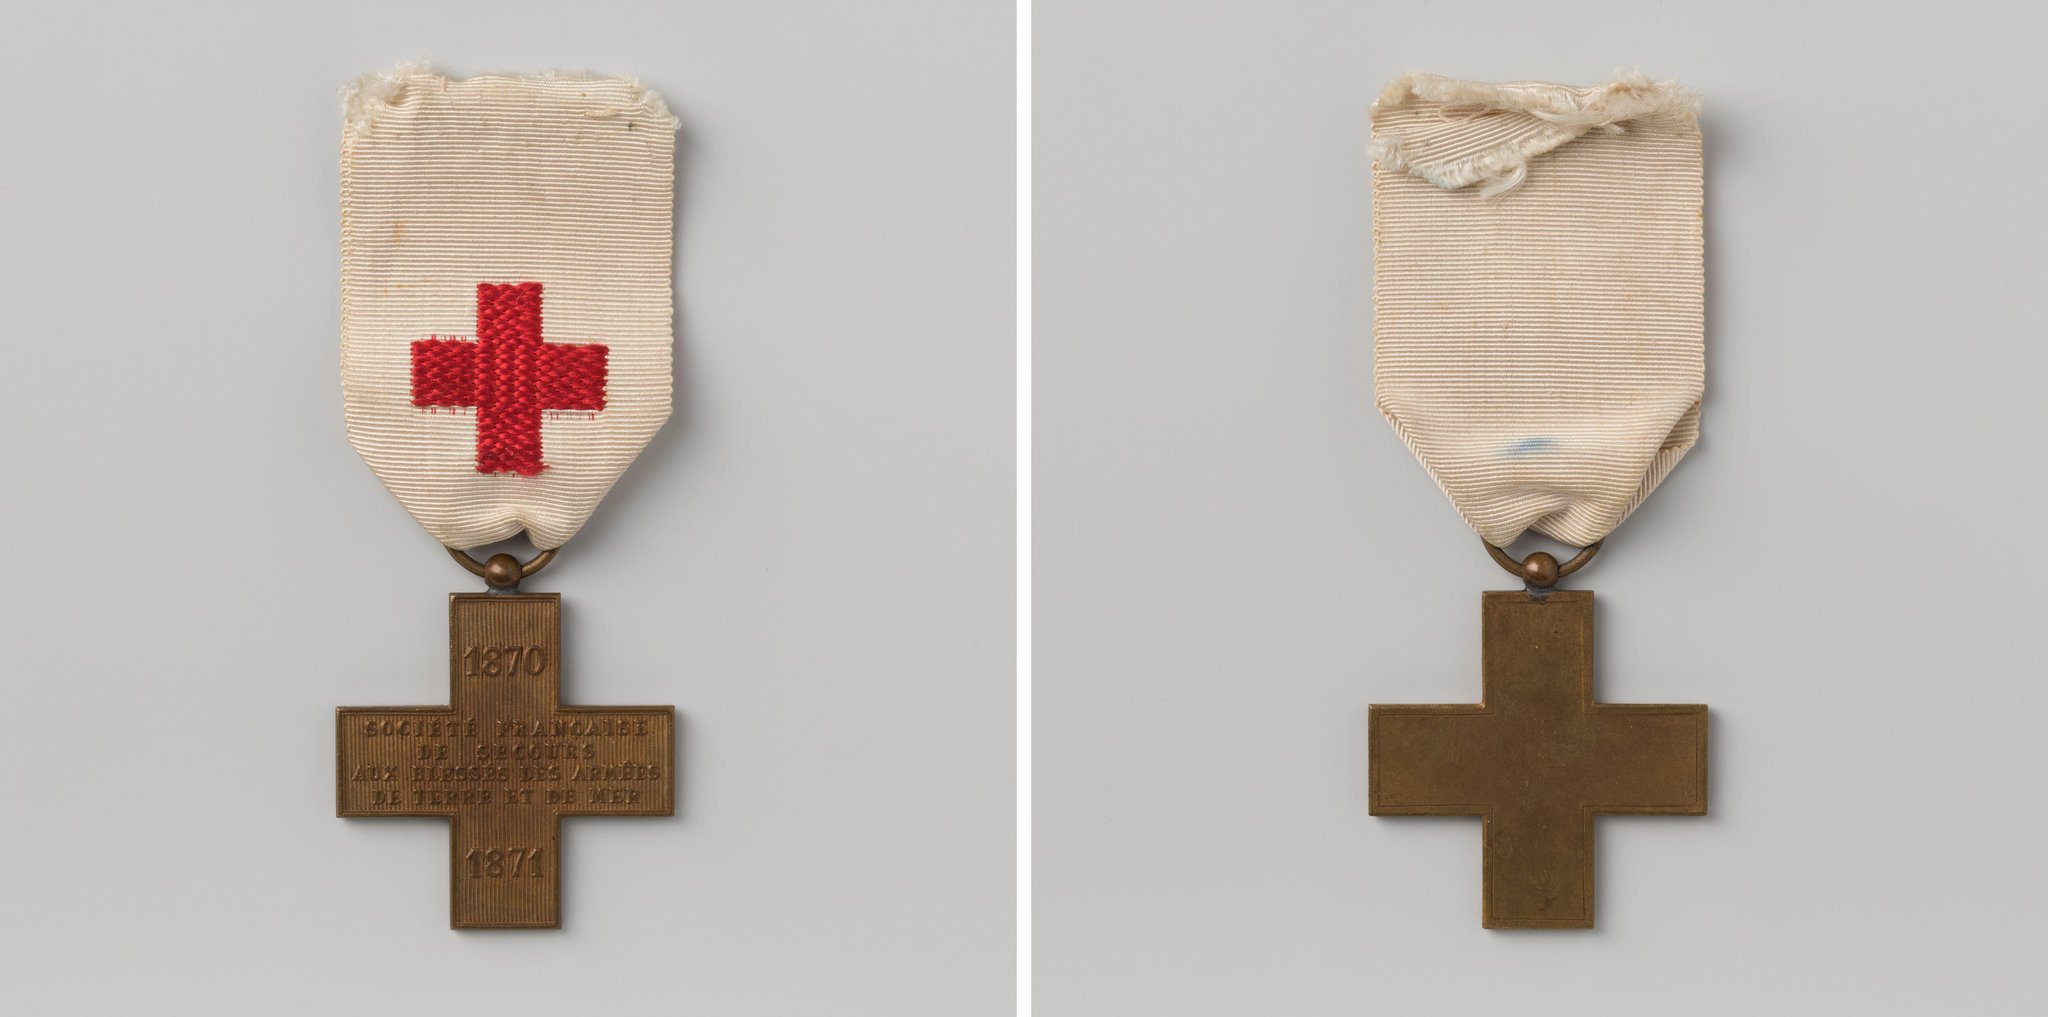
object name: history medal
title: Erekruis 1870-1871 van de Franse Vereniging tot Redding van Oorlogsgewonden 1871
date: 1871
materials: bronze, textile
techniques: striking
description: Eenzijdig bronzen kruis met oog en draagring aan een wit lint met geborduurd rood kruis, op het kruis twee jaartallen en vier regels tekst.